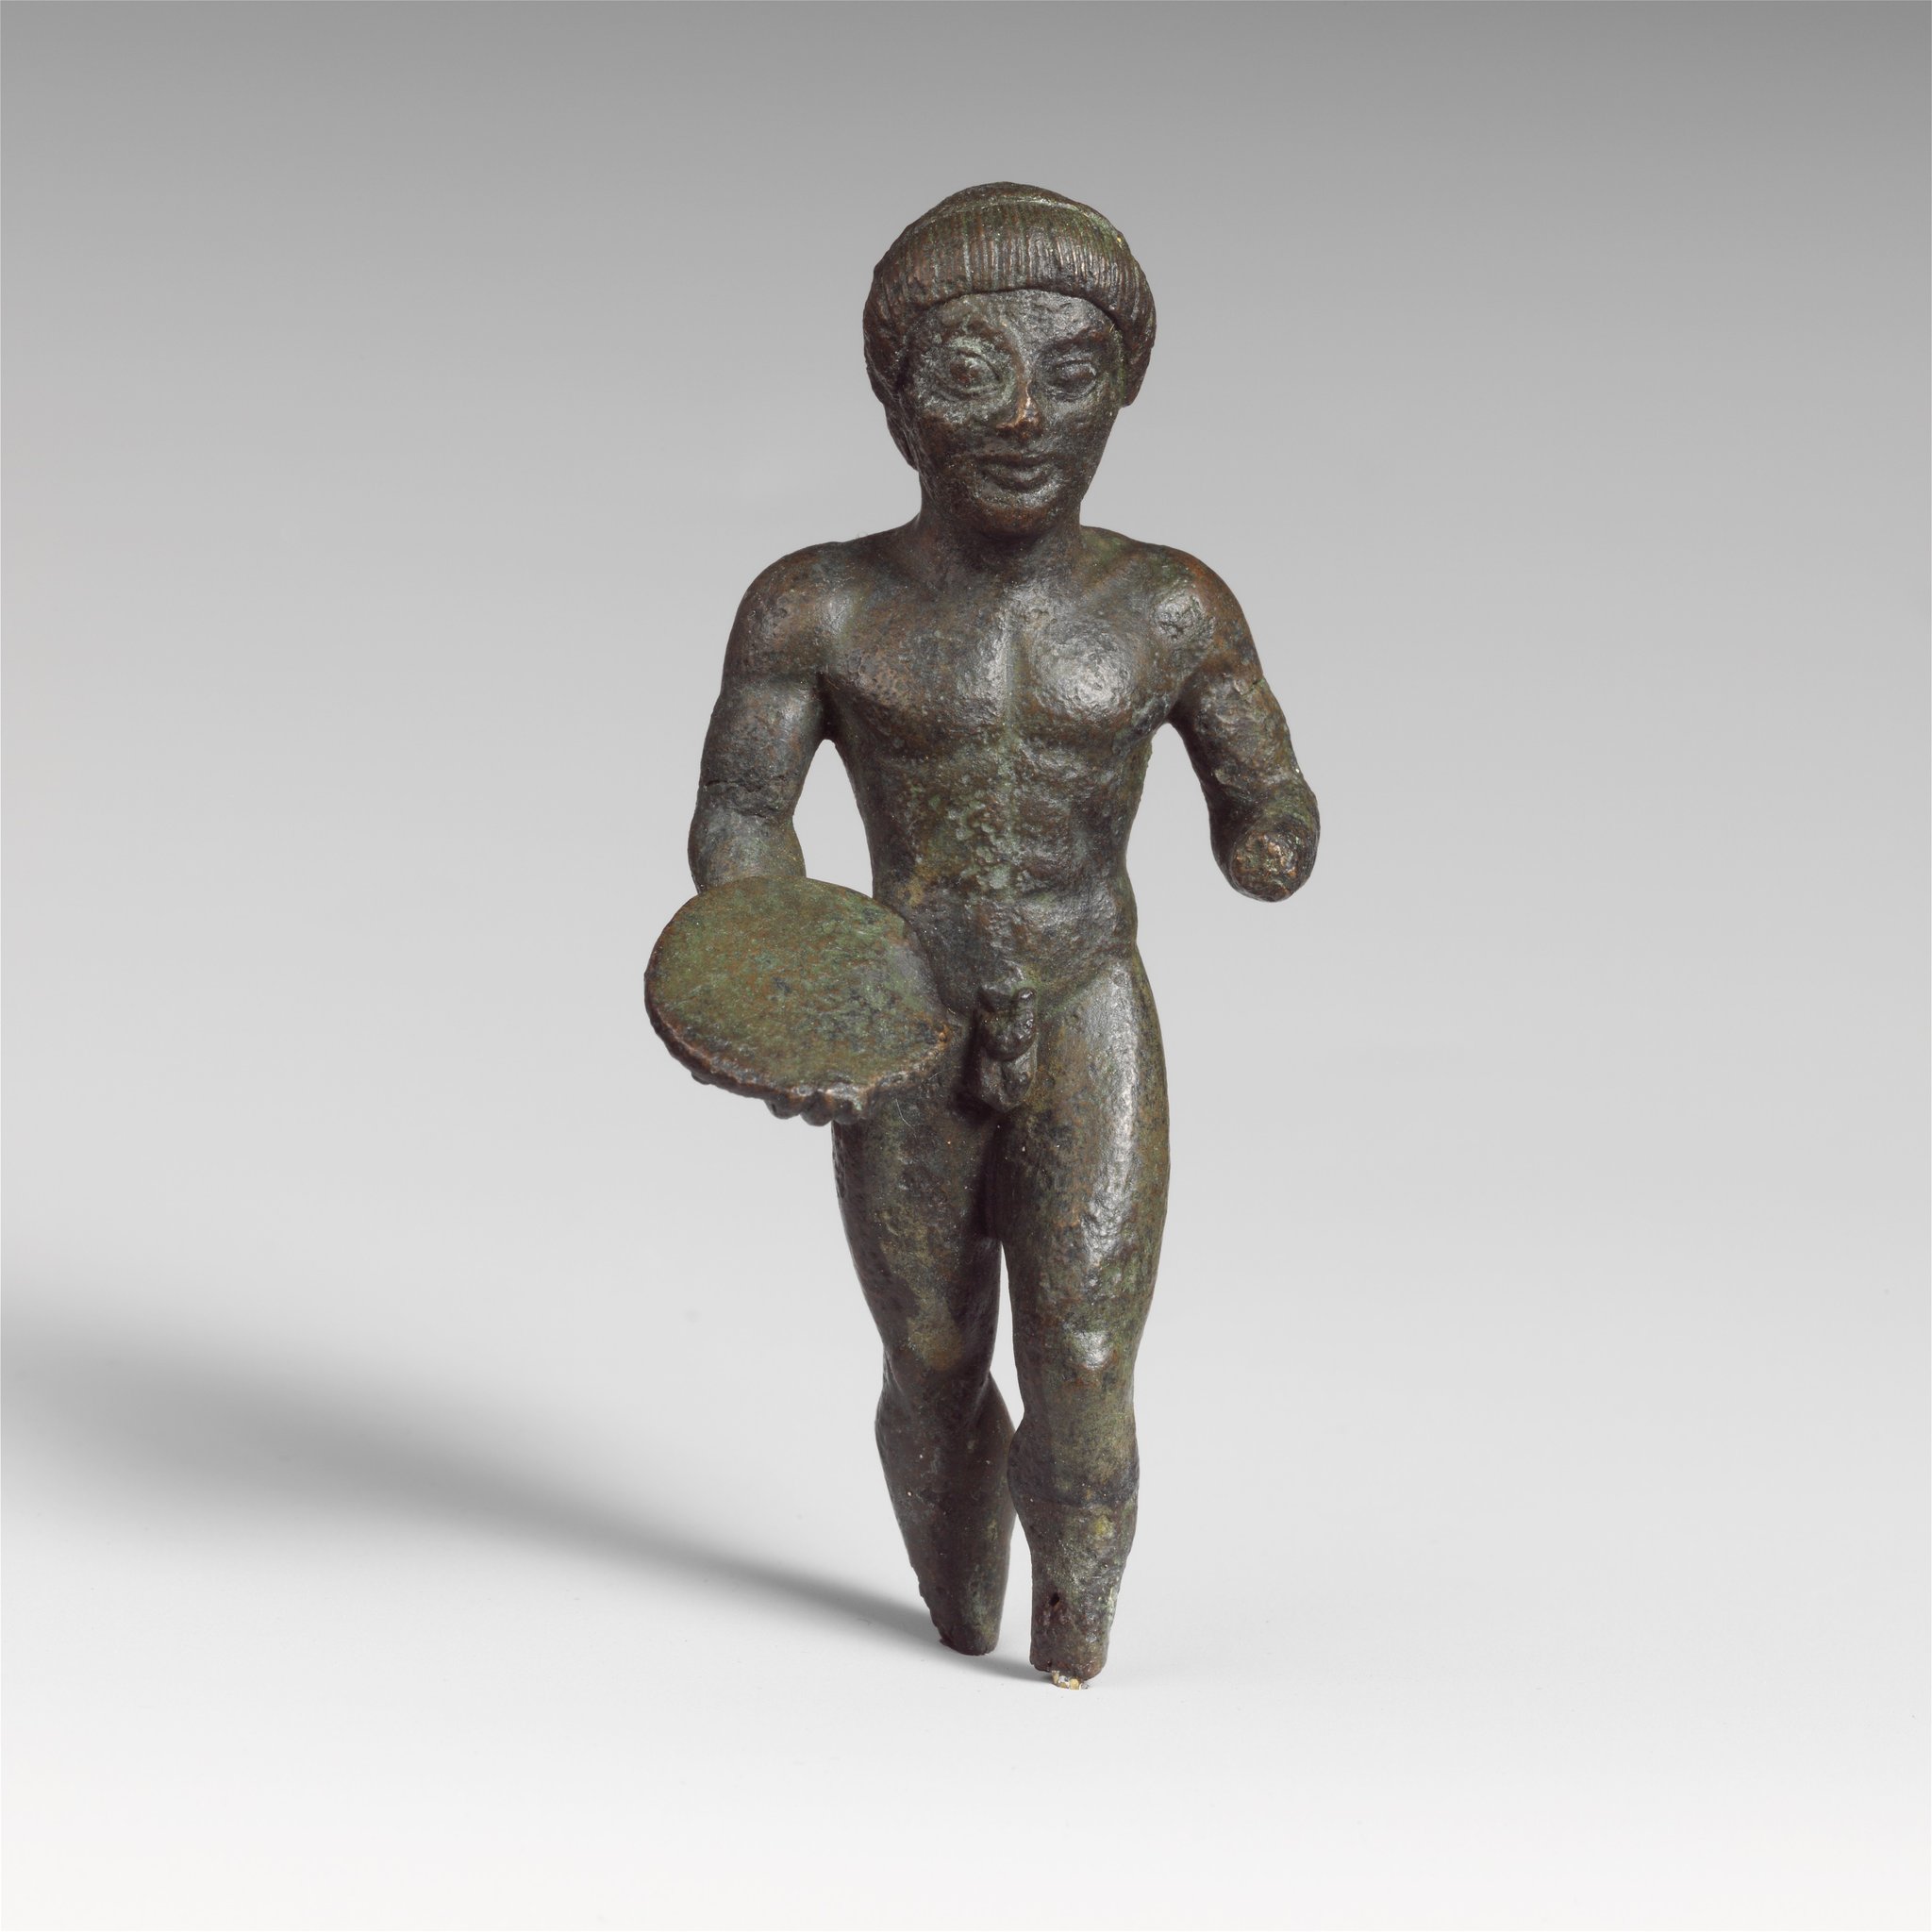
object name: statuette of a diskos thrower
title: Bronze statuette of a discus thrower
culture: etruscan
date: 500-401 BCE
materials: bronze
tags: male nudes